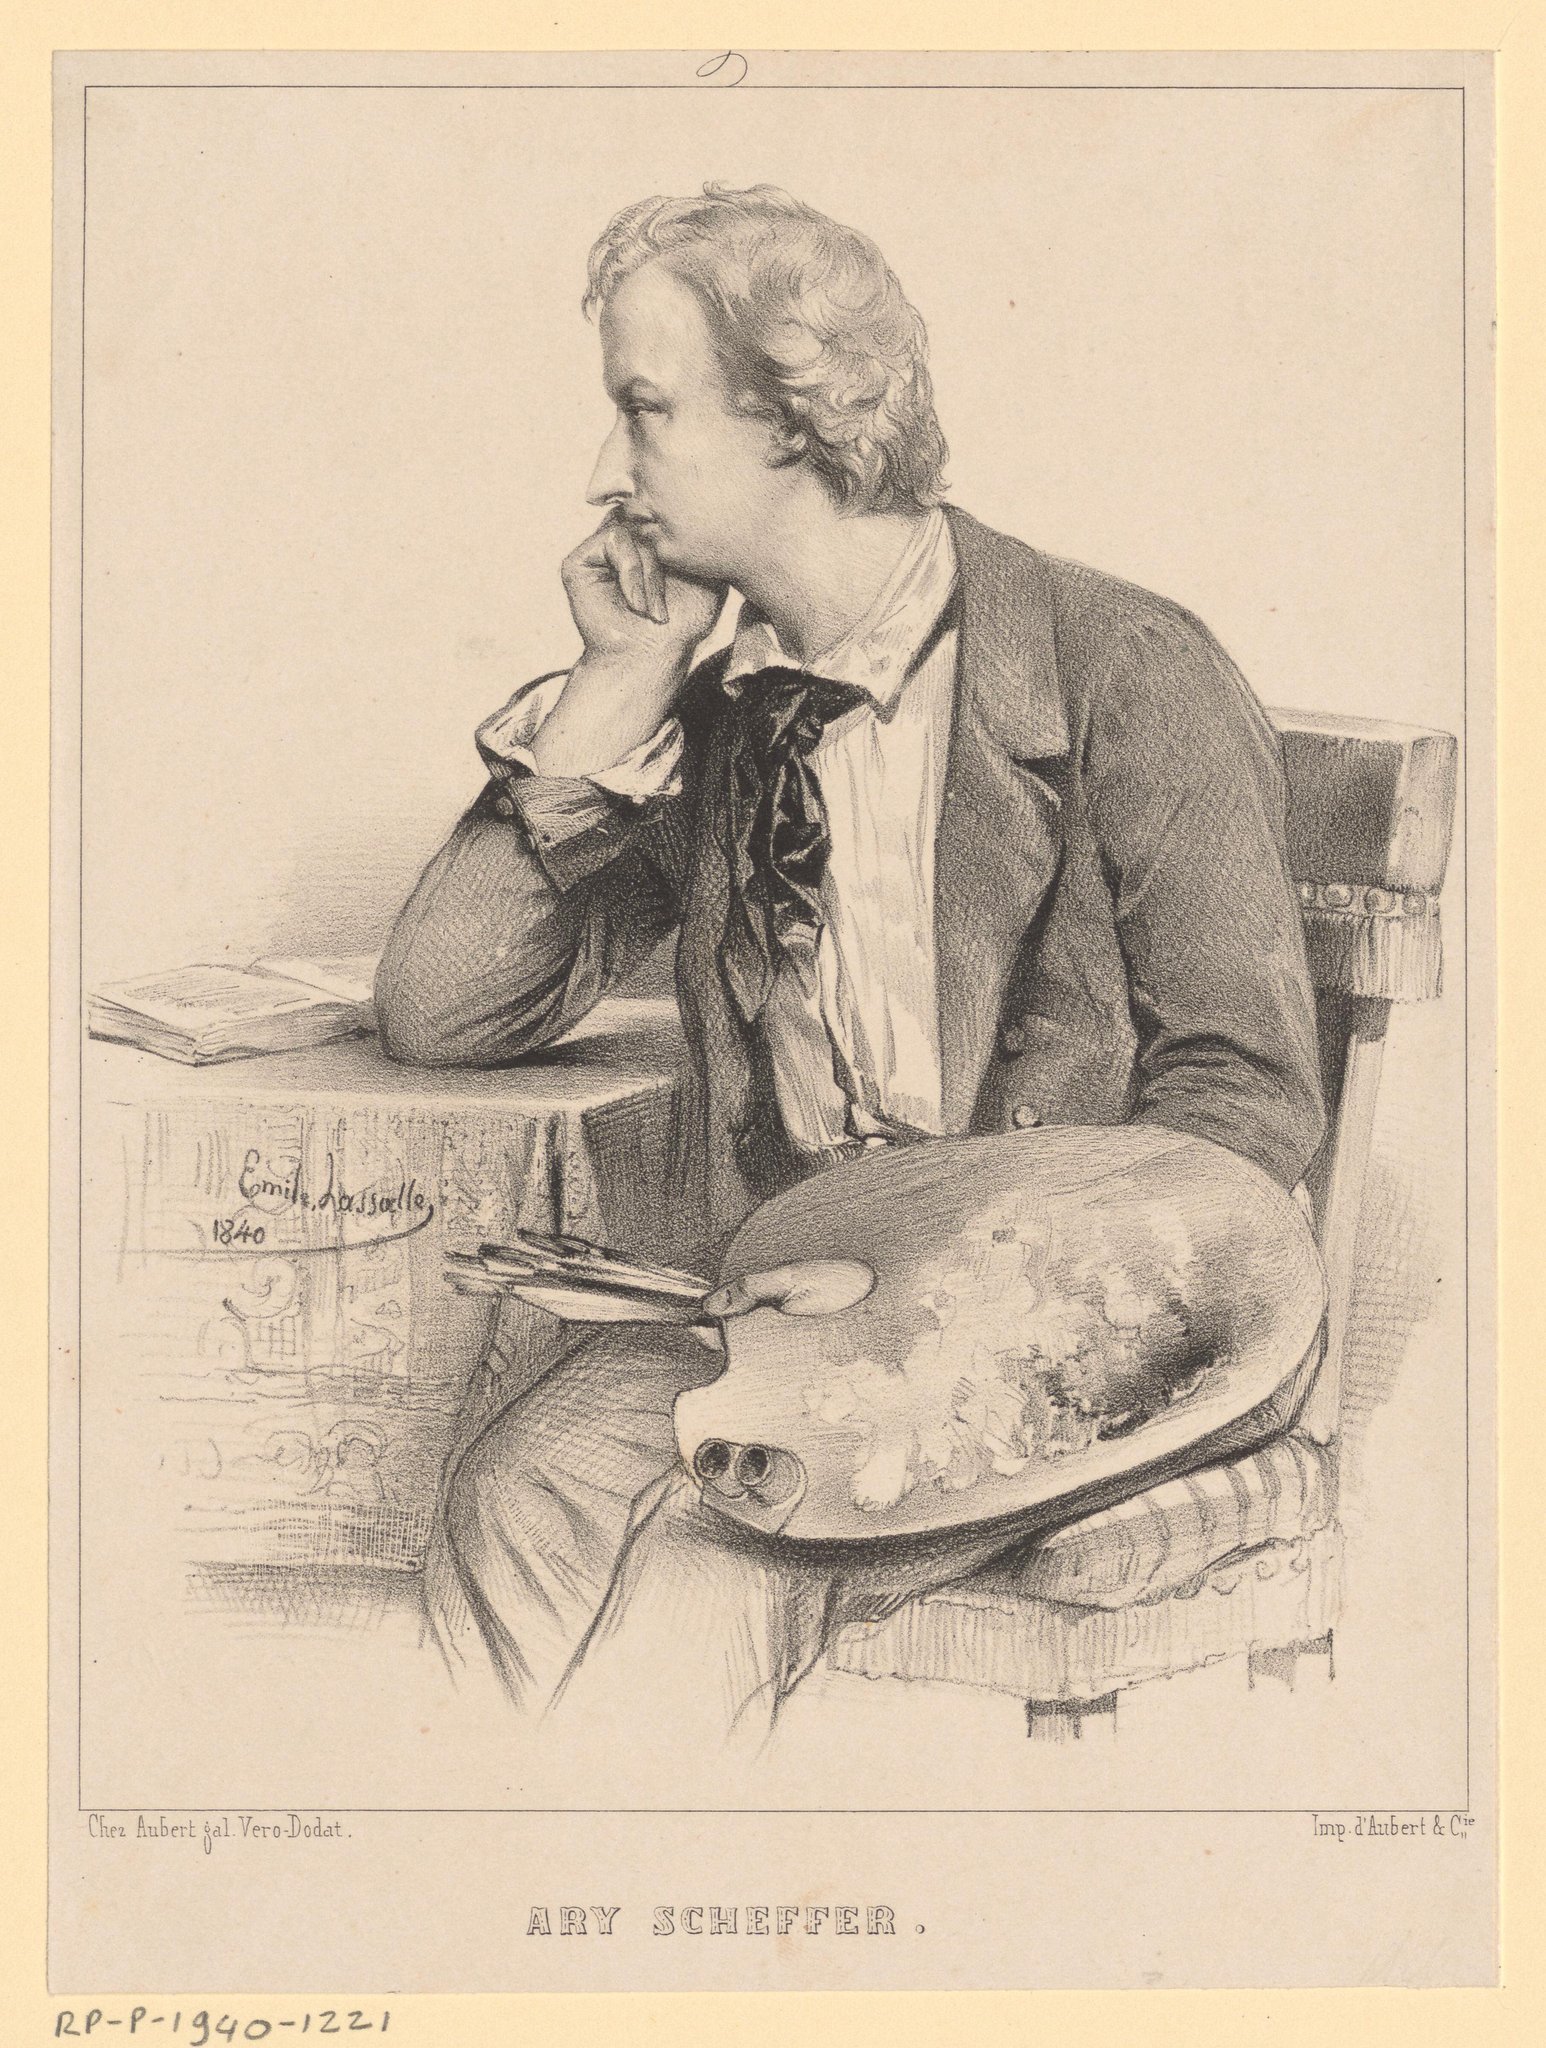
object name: print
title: Portretreeks van de pers, de literatuur en de kunsten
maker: émile lassalle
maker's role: print maker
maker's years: 1813-1871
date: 1841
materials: paper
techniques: lithograph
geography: paris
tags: dordrecht, painter, print maker, draughtsman, sculptor, ary scheffer, historical persons, portrait, self-portrait of painter, tools, implements of painter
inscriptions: collector's mark: Lugt 2228, collector's mark: Lugt 2760